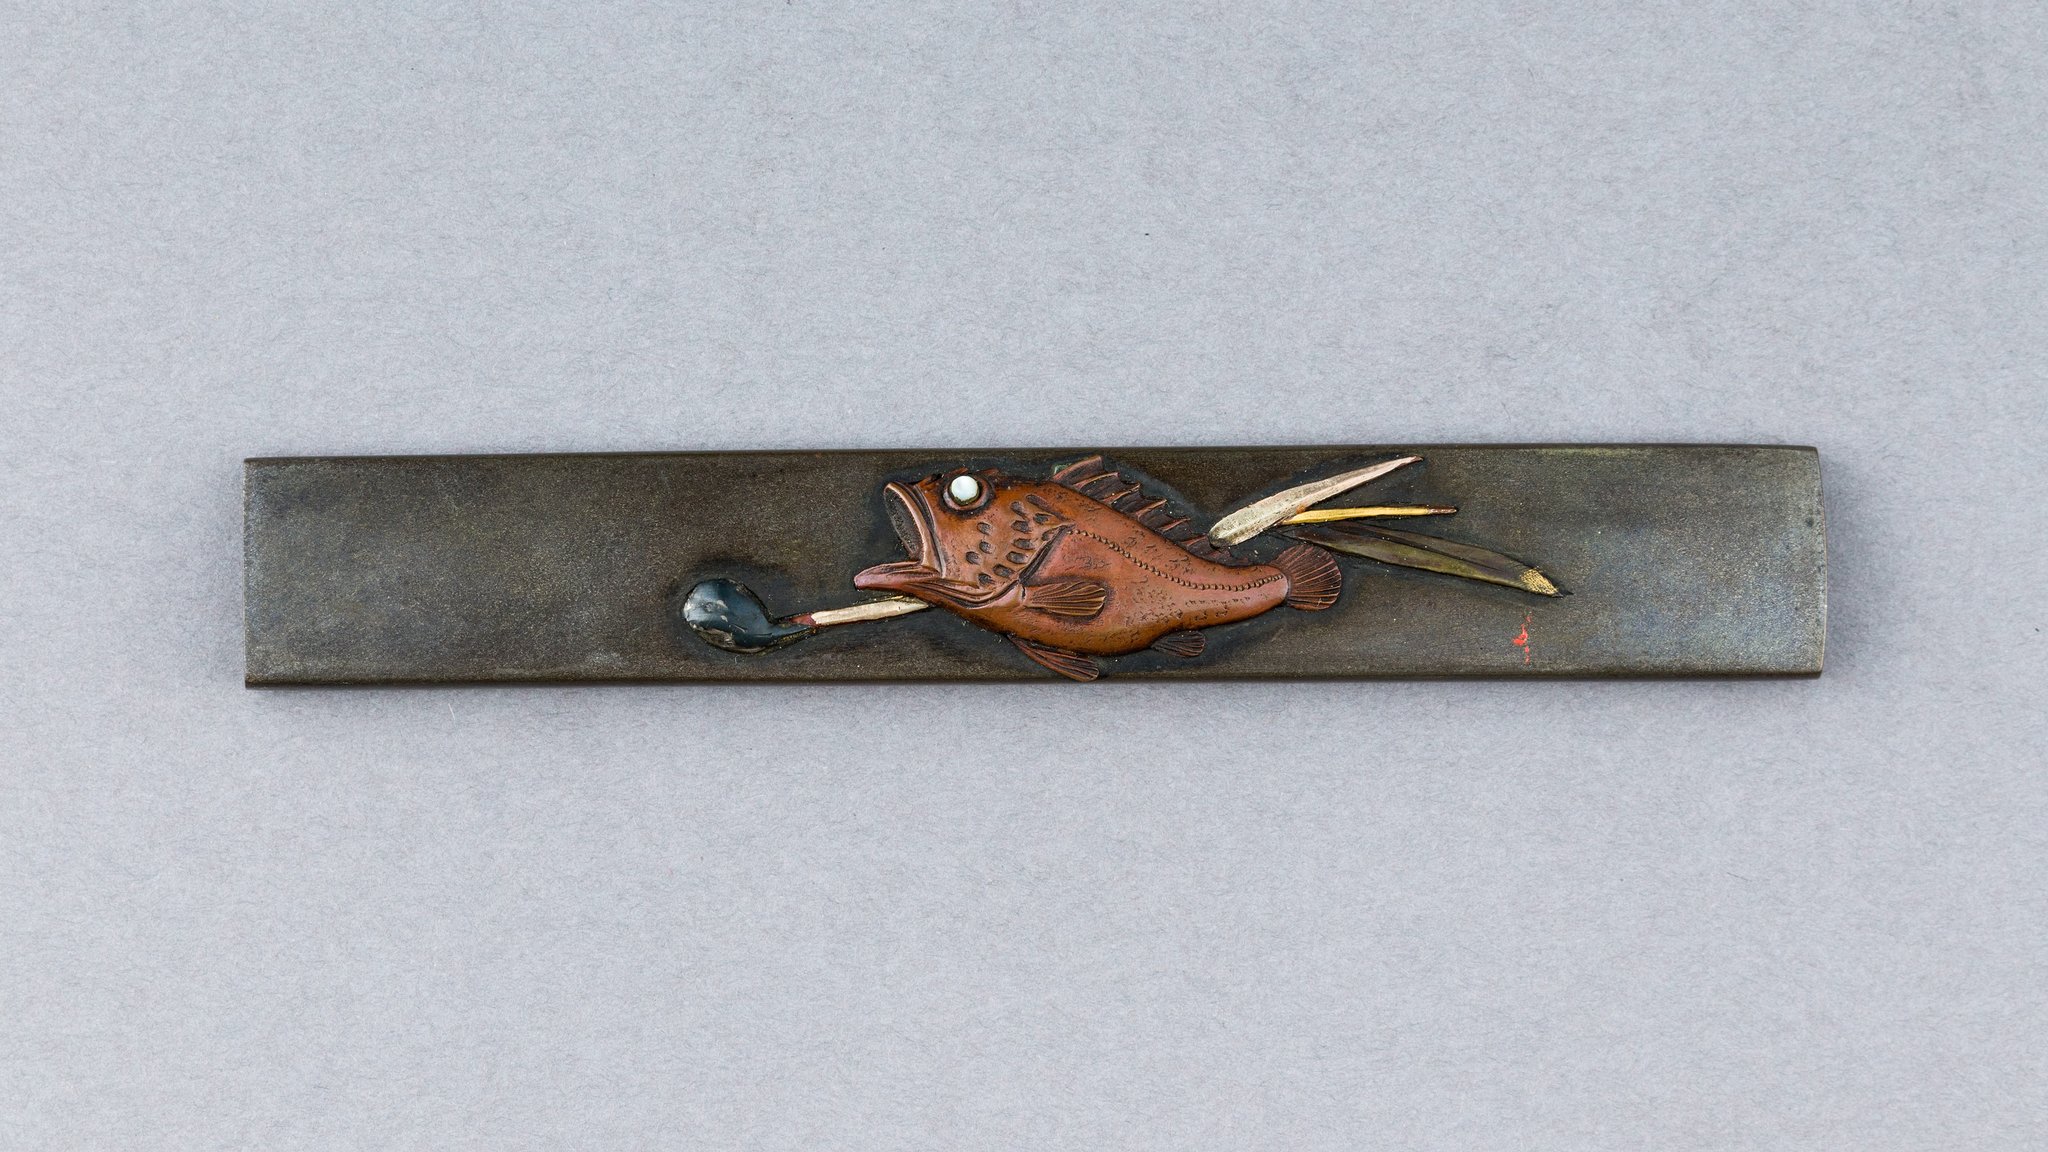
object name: knife handle kozuka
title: Knife Handle (Kozuka)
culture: japanese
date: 1615-1868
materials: copper, silver alloy, gold, mother of pearl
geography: japan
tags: fish